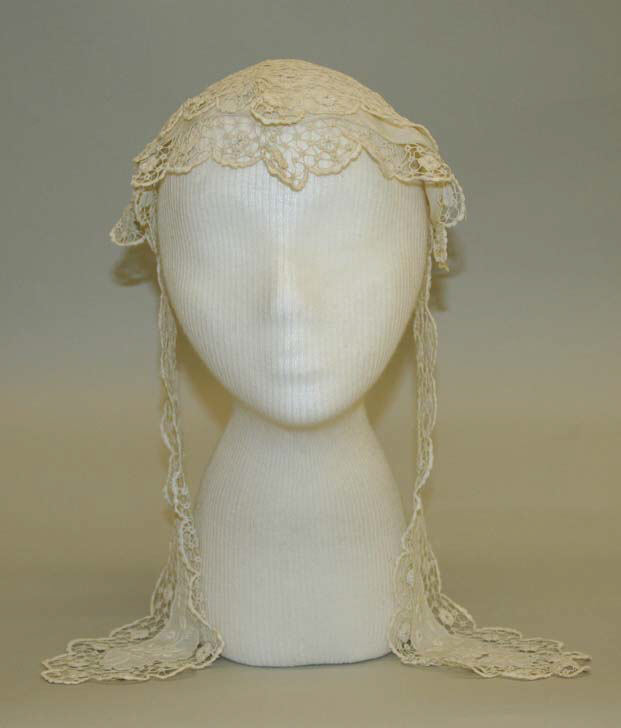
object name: cap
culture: american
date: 1860-1869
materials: cotton